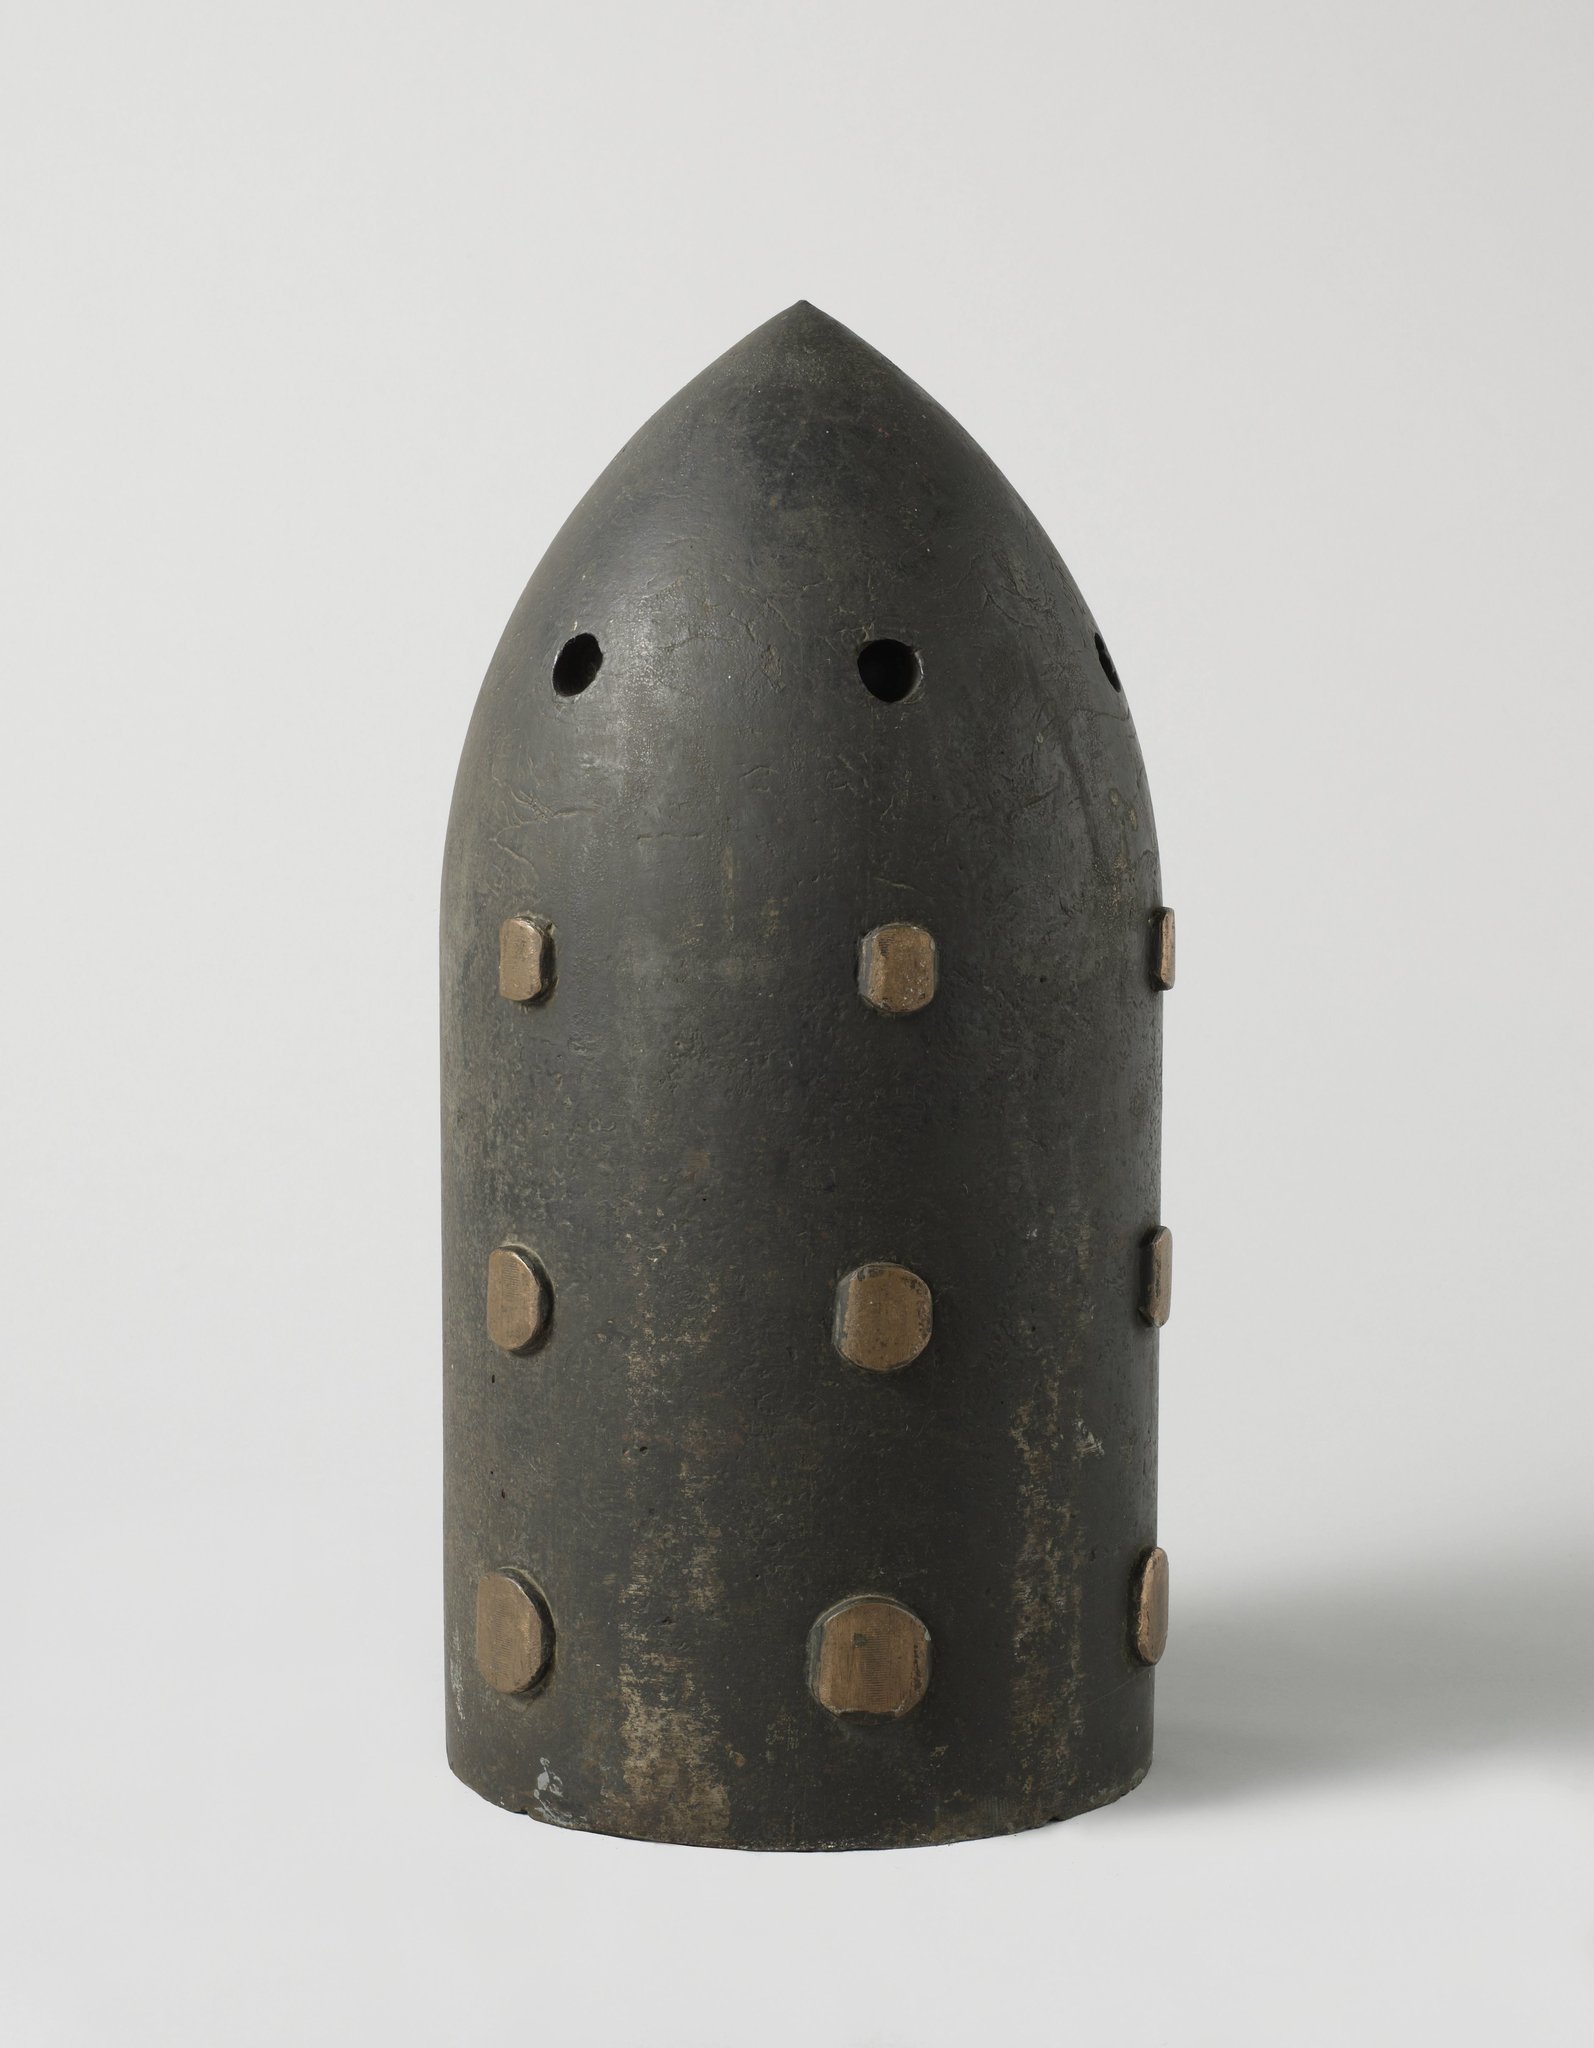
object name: bullet ammunition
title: 23-cm Palliser Shot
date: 1868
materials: brass, bronze, iron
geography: woolwich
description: De Palliser shot MK I 9 inch RML werden van 1867 geproduceerd. Palliser kogels waren gehard door een koelingsproces (zgn. 'glasharde kogels'). Kogels waren projectielen zonder spinglading: de lichtere kalibers waren massief, de zwaardere werden hol gemaakt vanwege problemen bij het gieten en afkoelen. Zij waren bedoeld voor getrokken voorlaadgeschut. De Nederlandse Marine gebruikte vanaf 1867 23 cm Armstrong geschut.